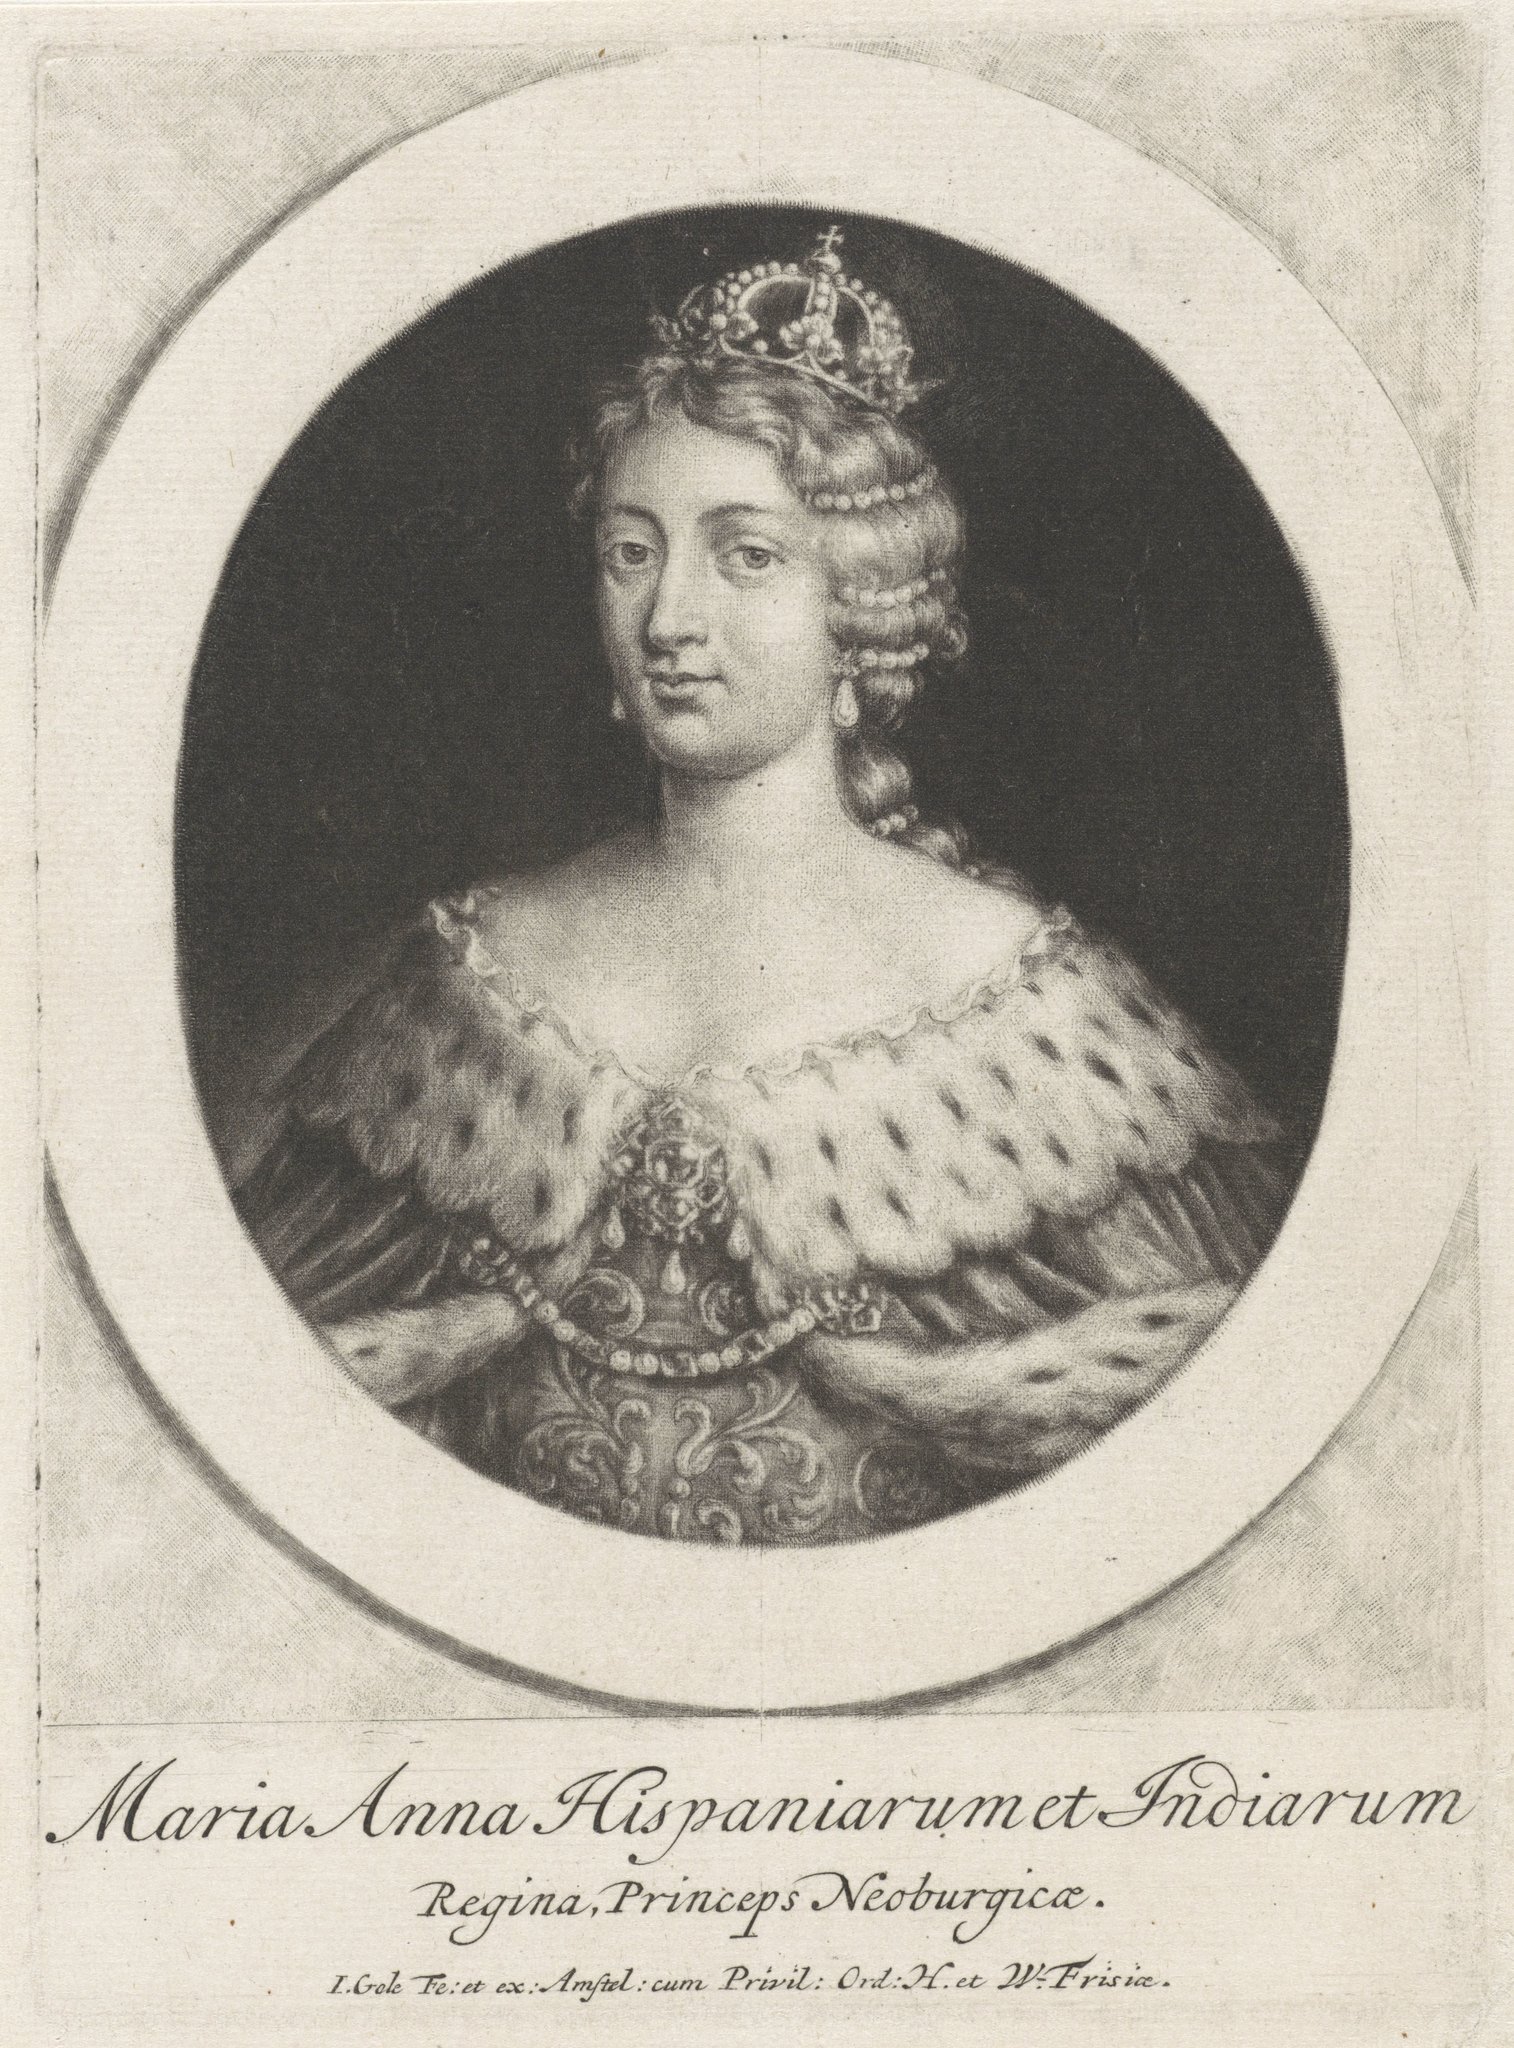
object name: print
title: Portret van koningin Maria Anna van Spanje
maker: jacob gole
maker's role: print maker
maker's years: 1660-1724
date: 1682-1724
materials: paper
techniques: engraving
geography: amsterdam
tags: crown (symbol of sovereignty), mantle, gown, dress (symbol of sovereignty)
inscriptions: collector's mark: Lugt 2228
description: Maria Anna, koningin van Spanje en prinses van Neuburg. Echtgenote van Karel II van Spanje. Ze draagt een kroon en een kroningsmantel.